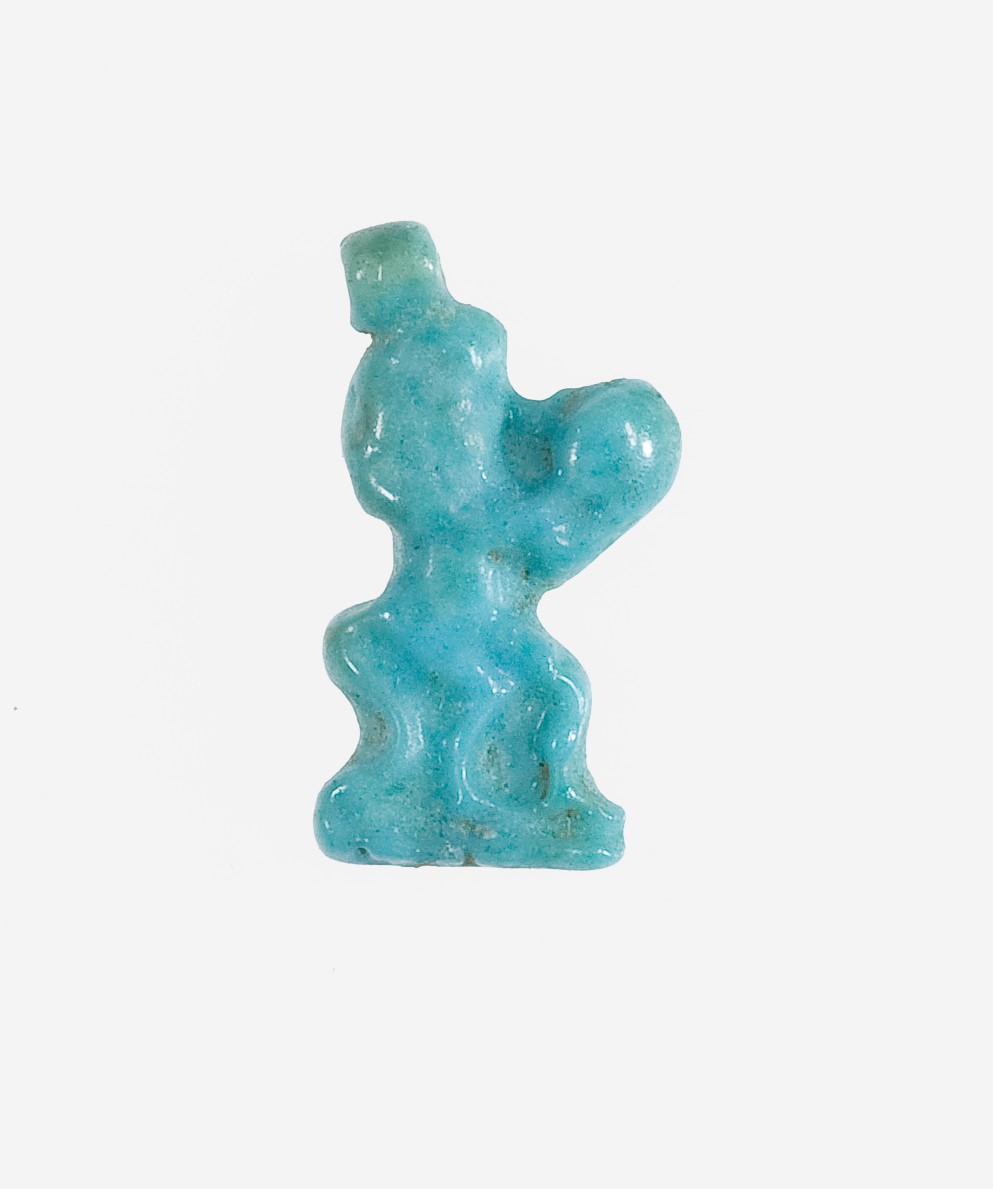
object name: pendant, be, tambourine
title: Amulet of Bes with tambourine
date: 1390-1352 BCE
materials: faience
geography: egypt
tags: bes